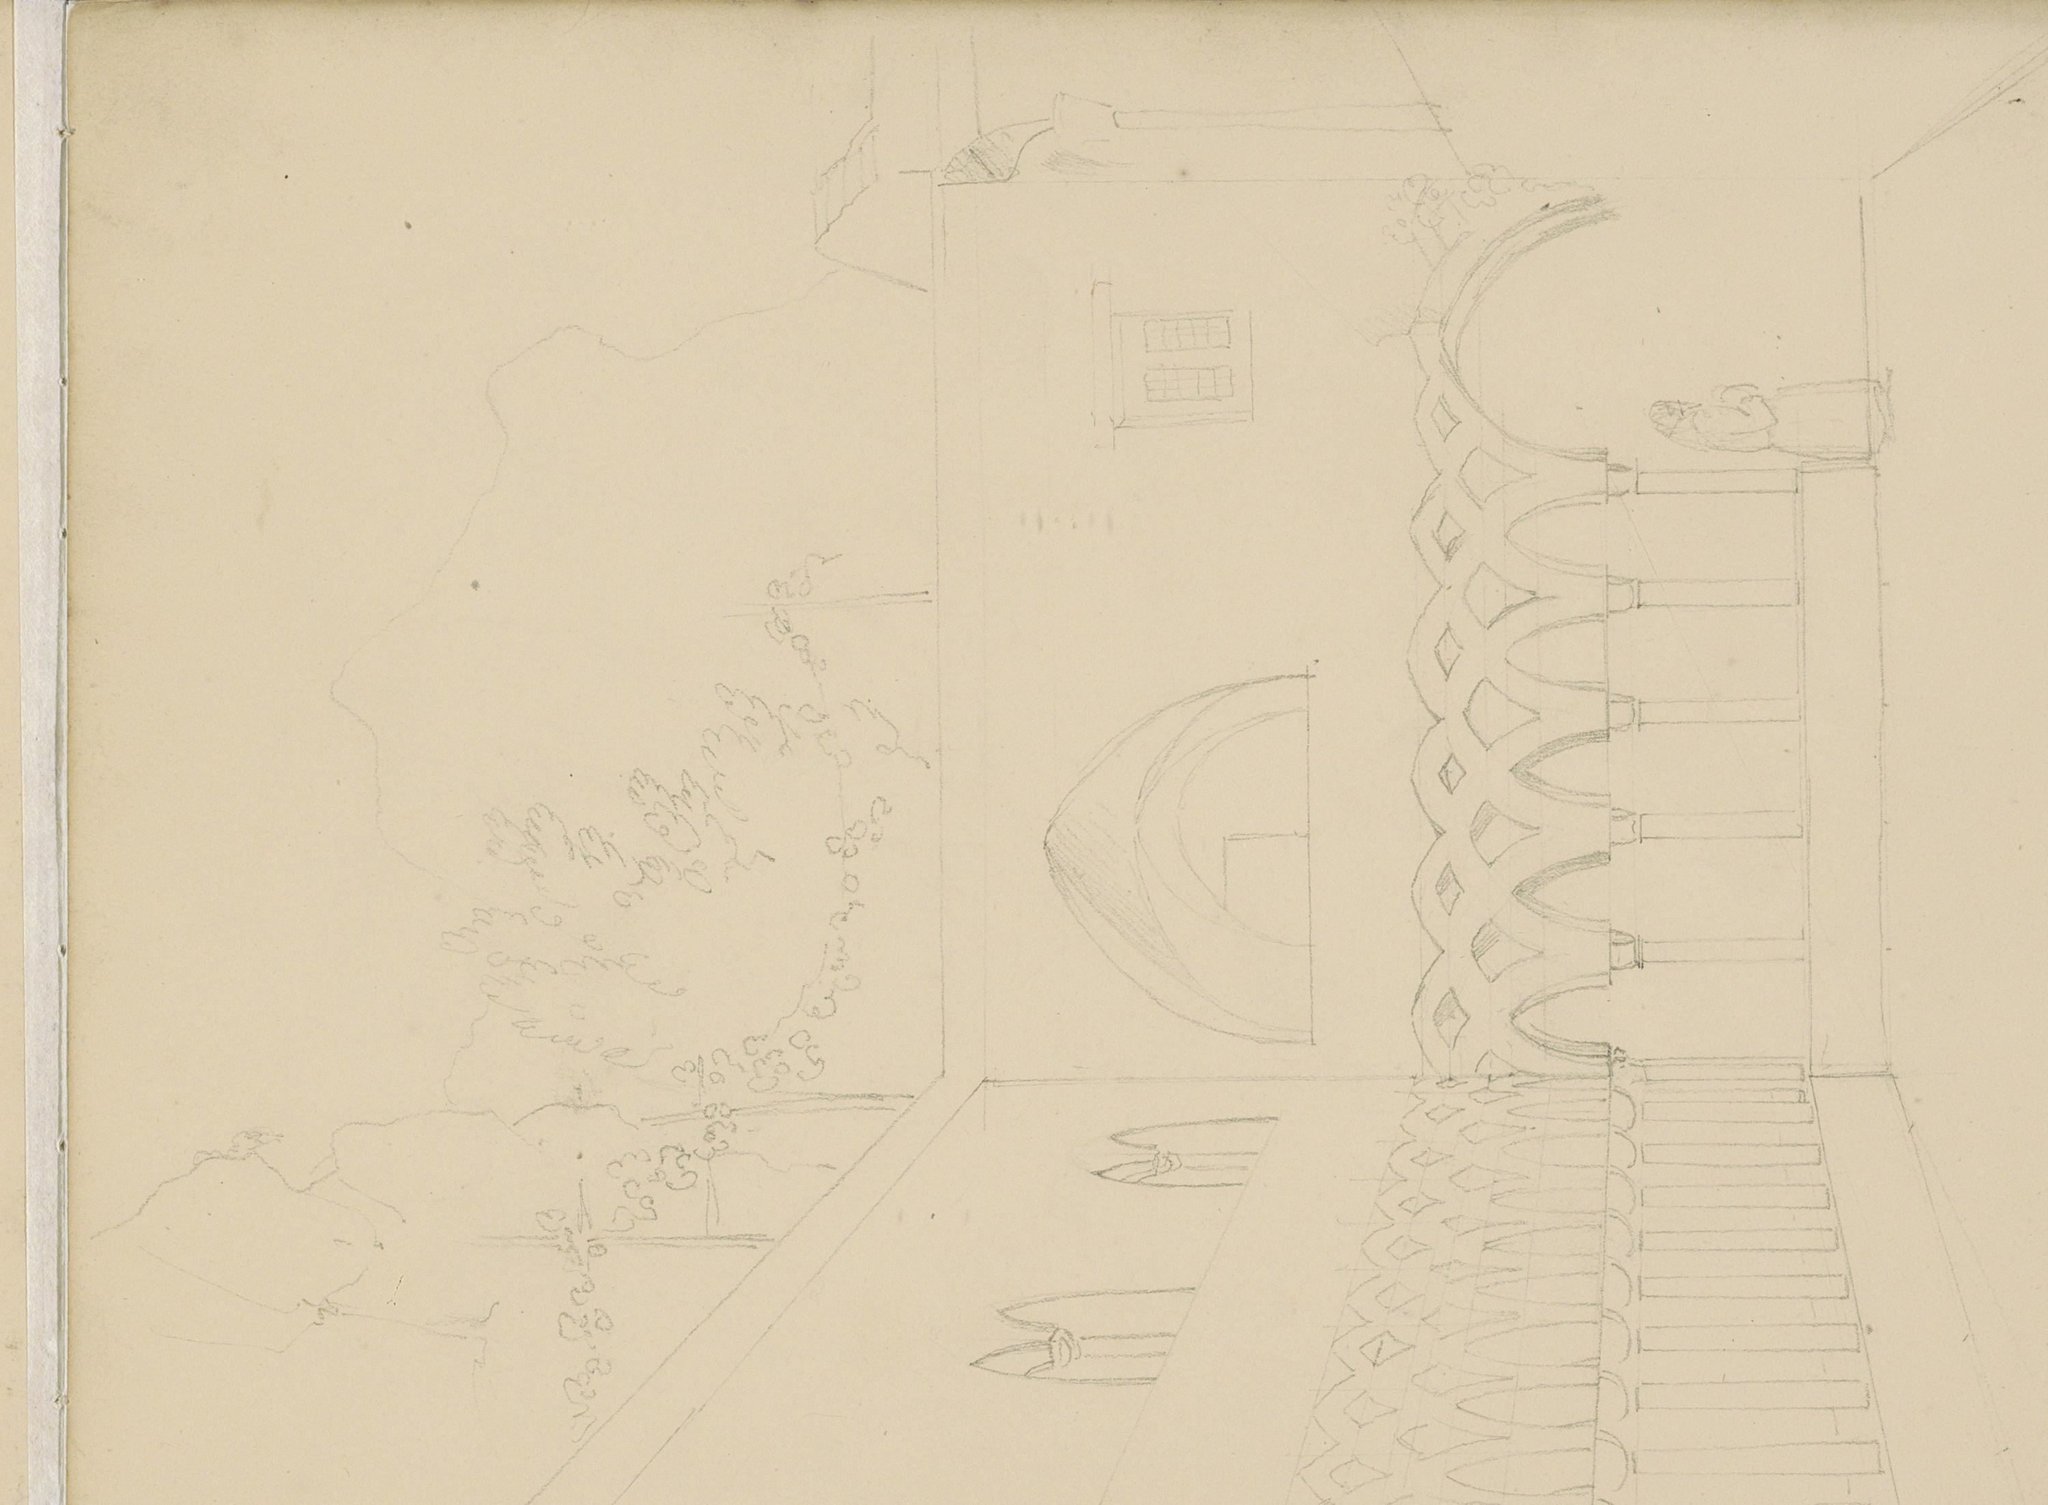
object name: sketchbook leaf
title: Vrouw op een binnenplaats te Amalfi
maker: jacobus everhardus josephus van den berg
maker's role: draughtsman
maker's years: 1802-1861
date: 1830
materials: paper, pencil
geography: amalfi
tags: standing figure, courtyard, amalfi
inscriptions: annotation: ‘amalfi n’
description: Blad 2 recto uit een schetsboek met 26 bladen.